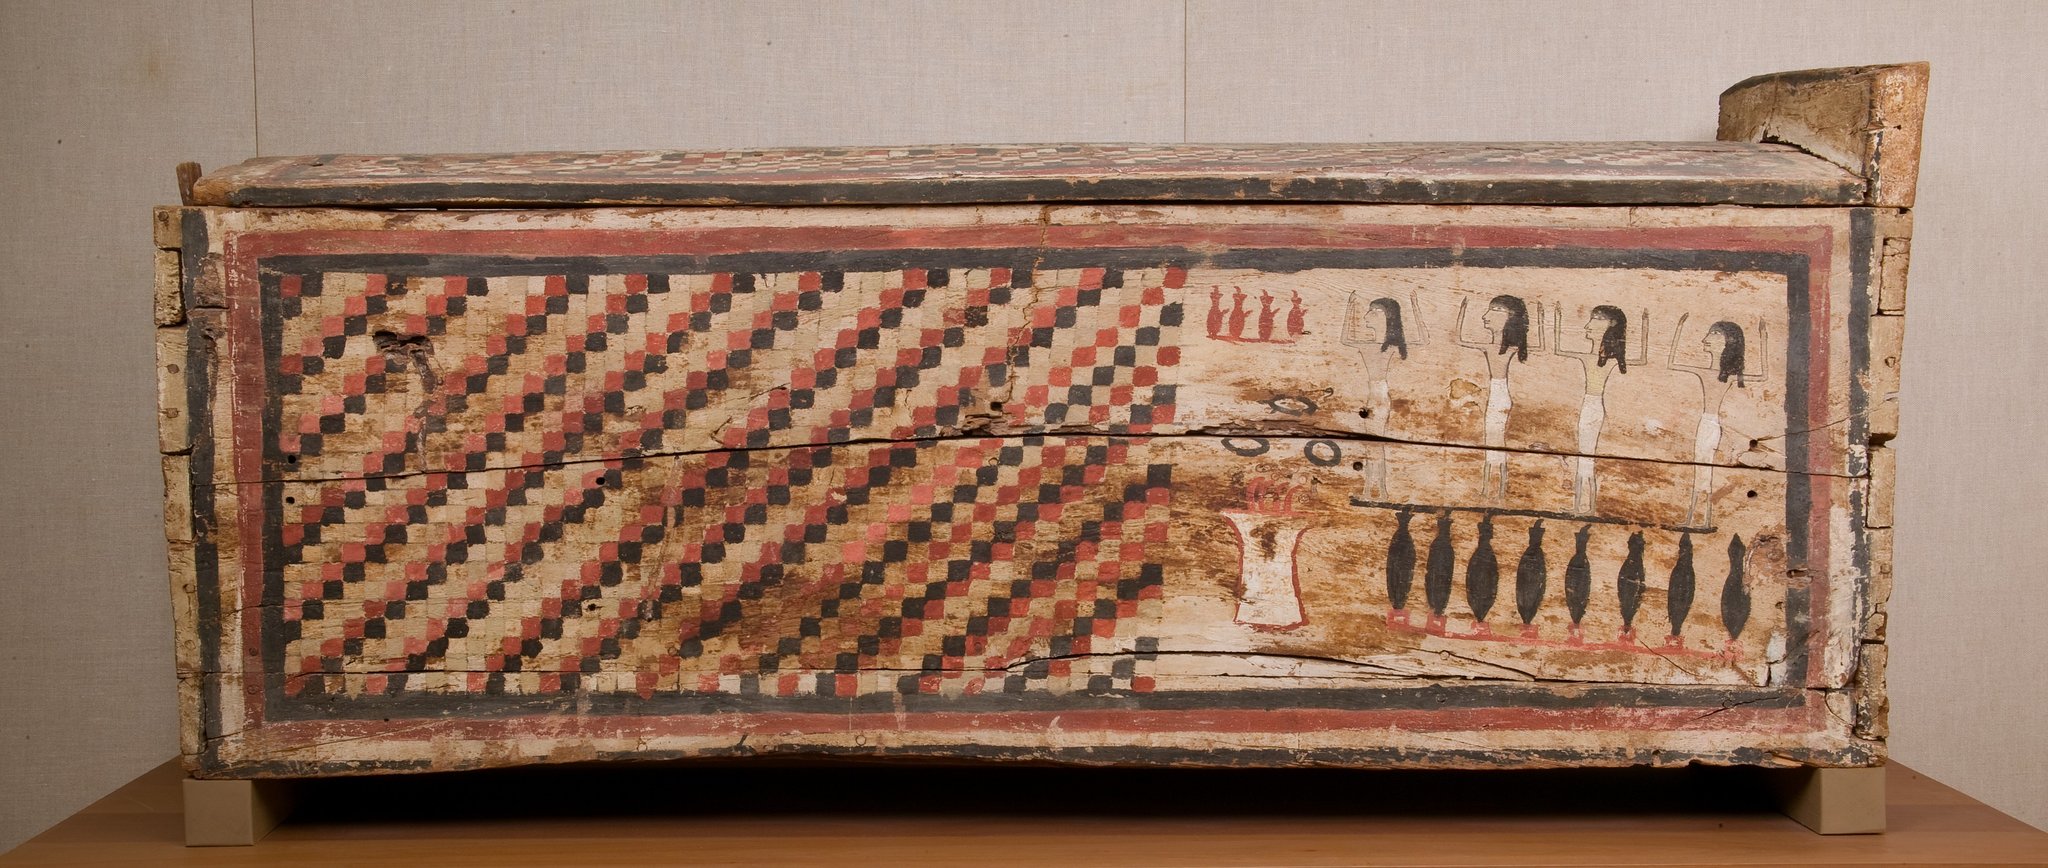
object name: coffin, teti, rectangular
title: Coffin of Teti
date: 1550-1458 BCE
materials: mortar, paint, plaster, wood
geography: egypt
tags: coffins